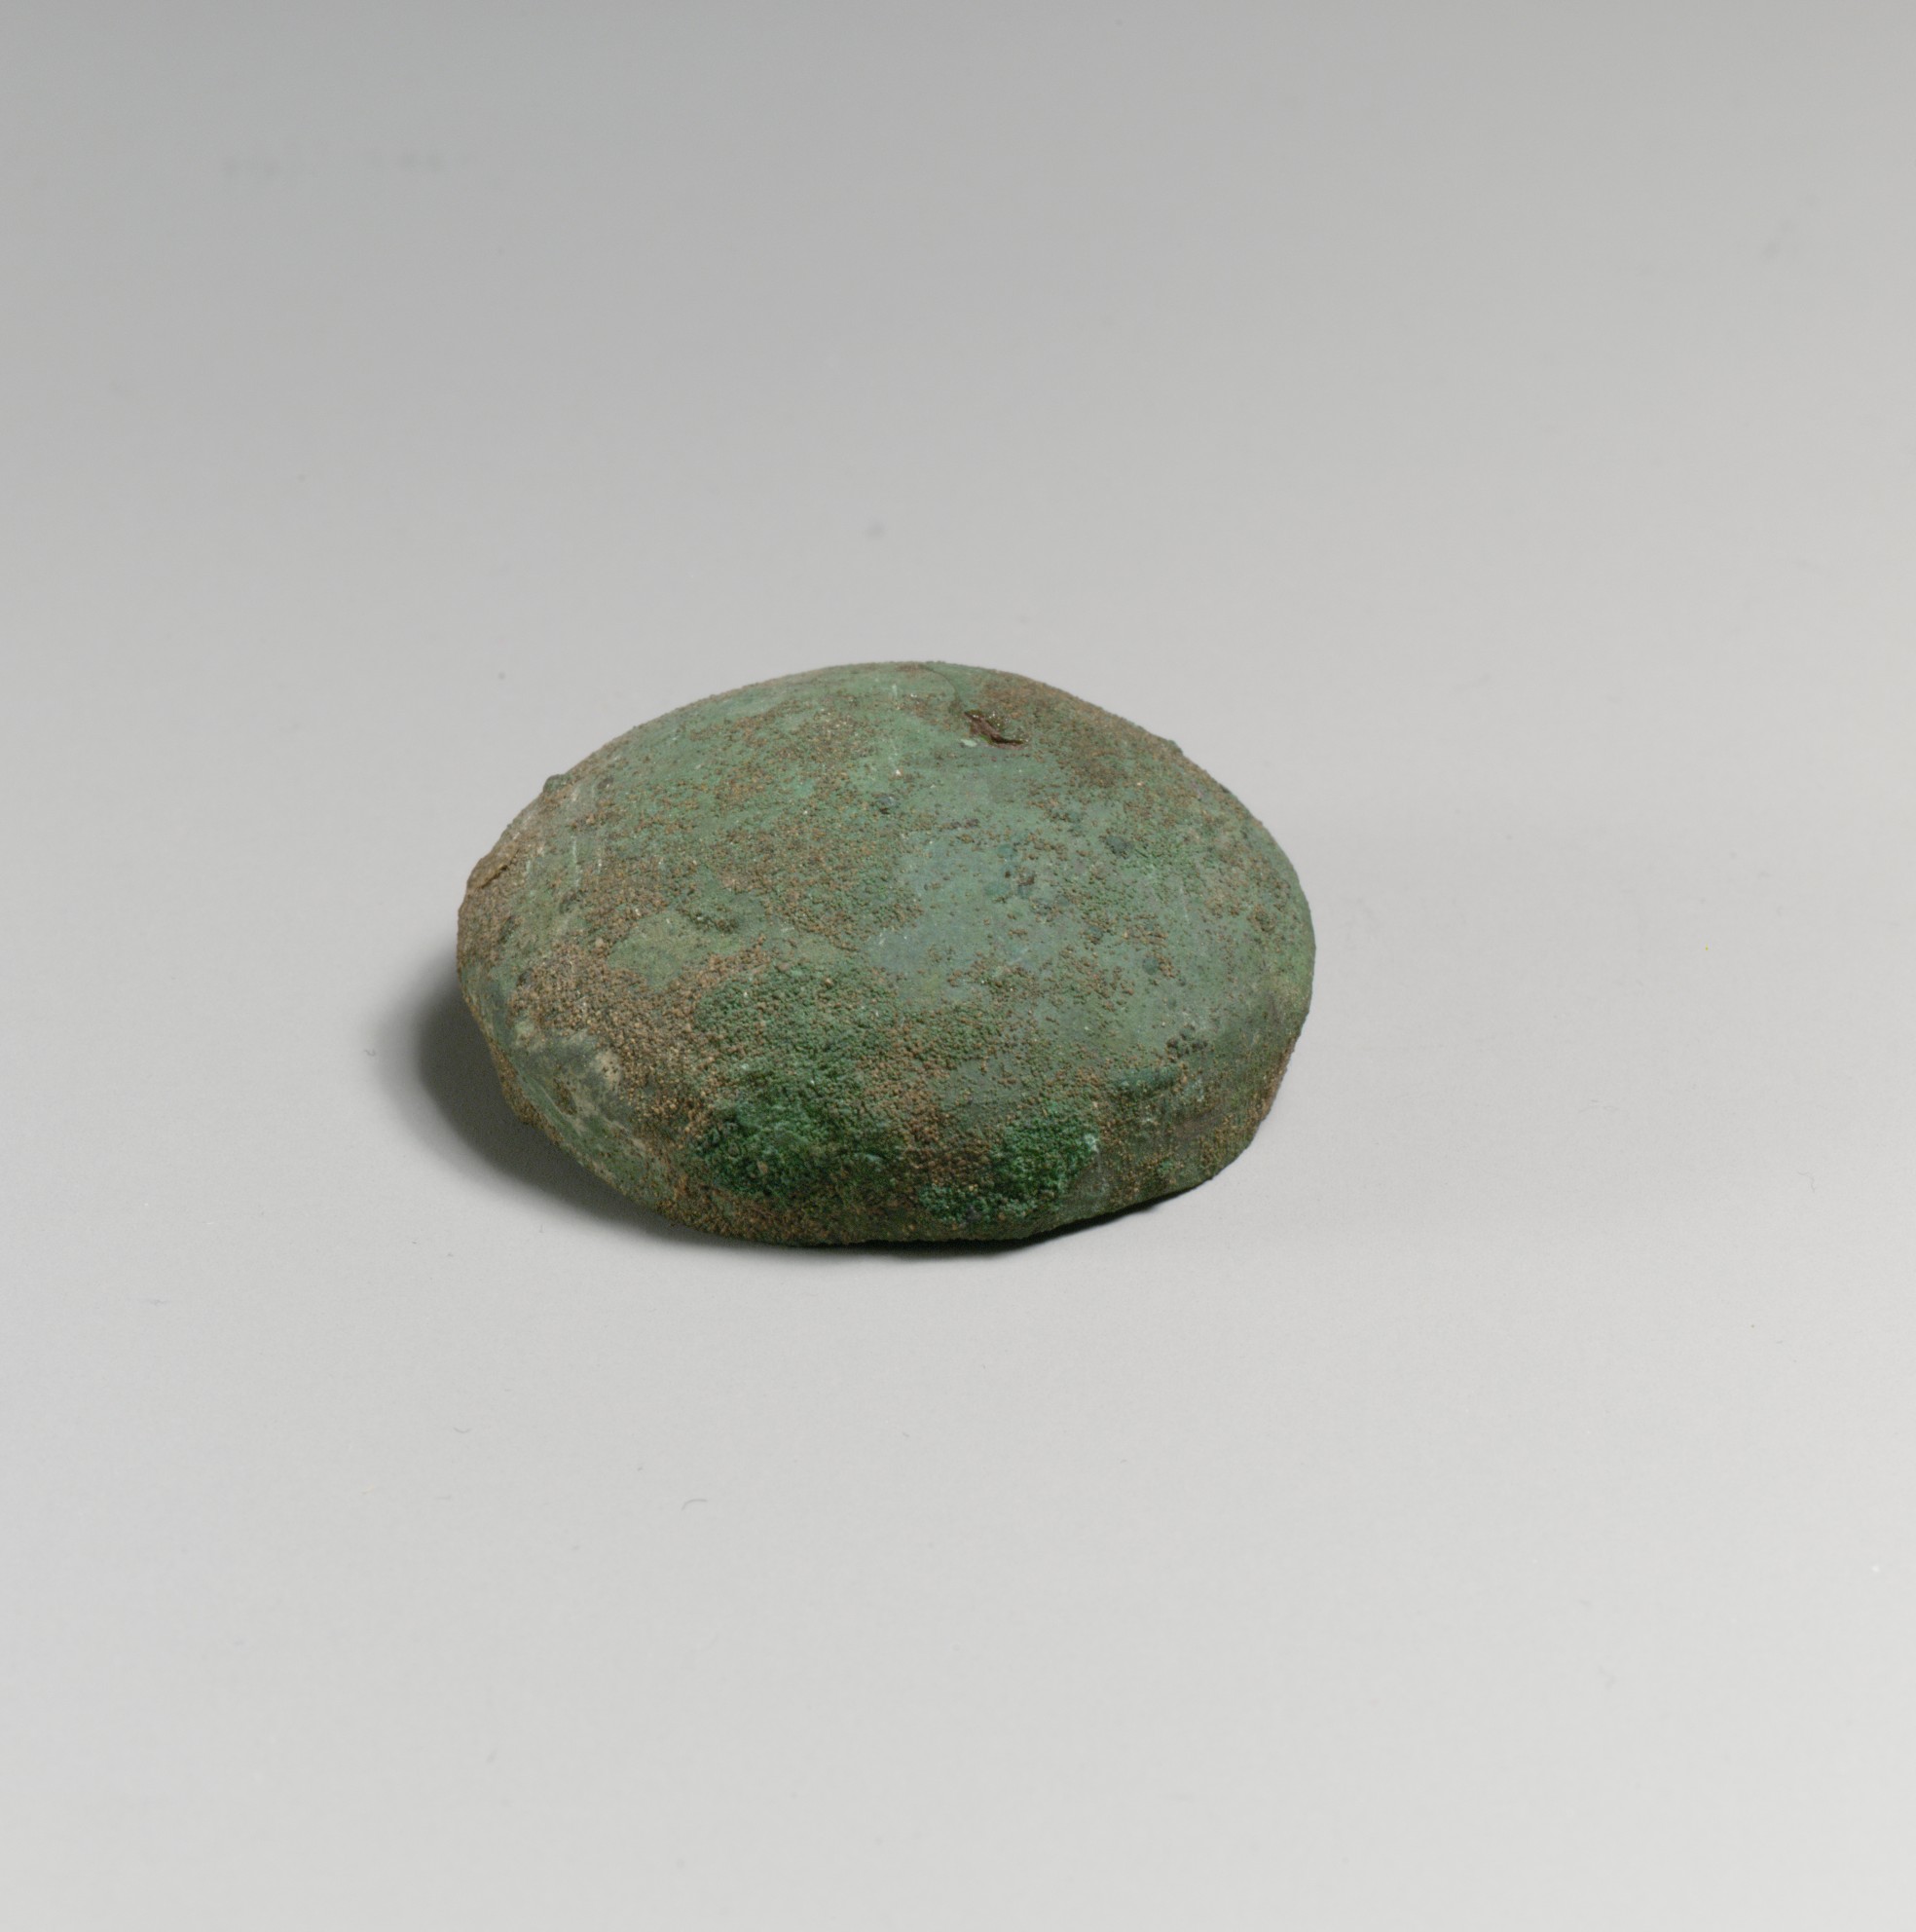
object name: lid or bos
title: Lid or boss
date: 7000 BCE-330 CE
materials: bronze